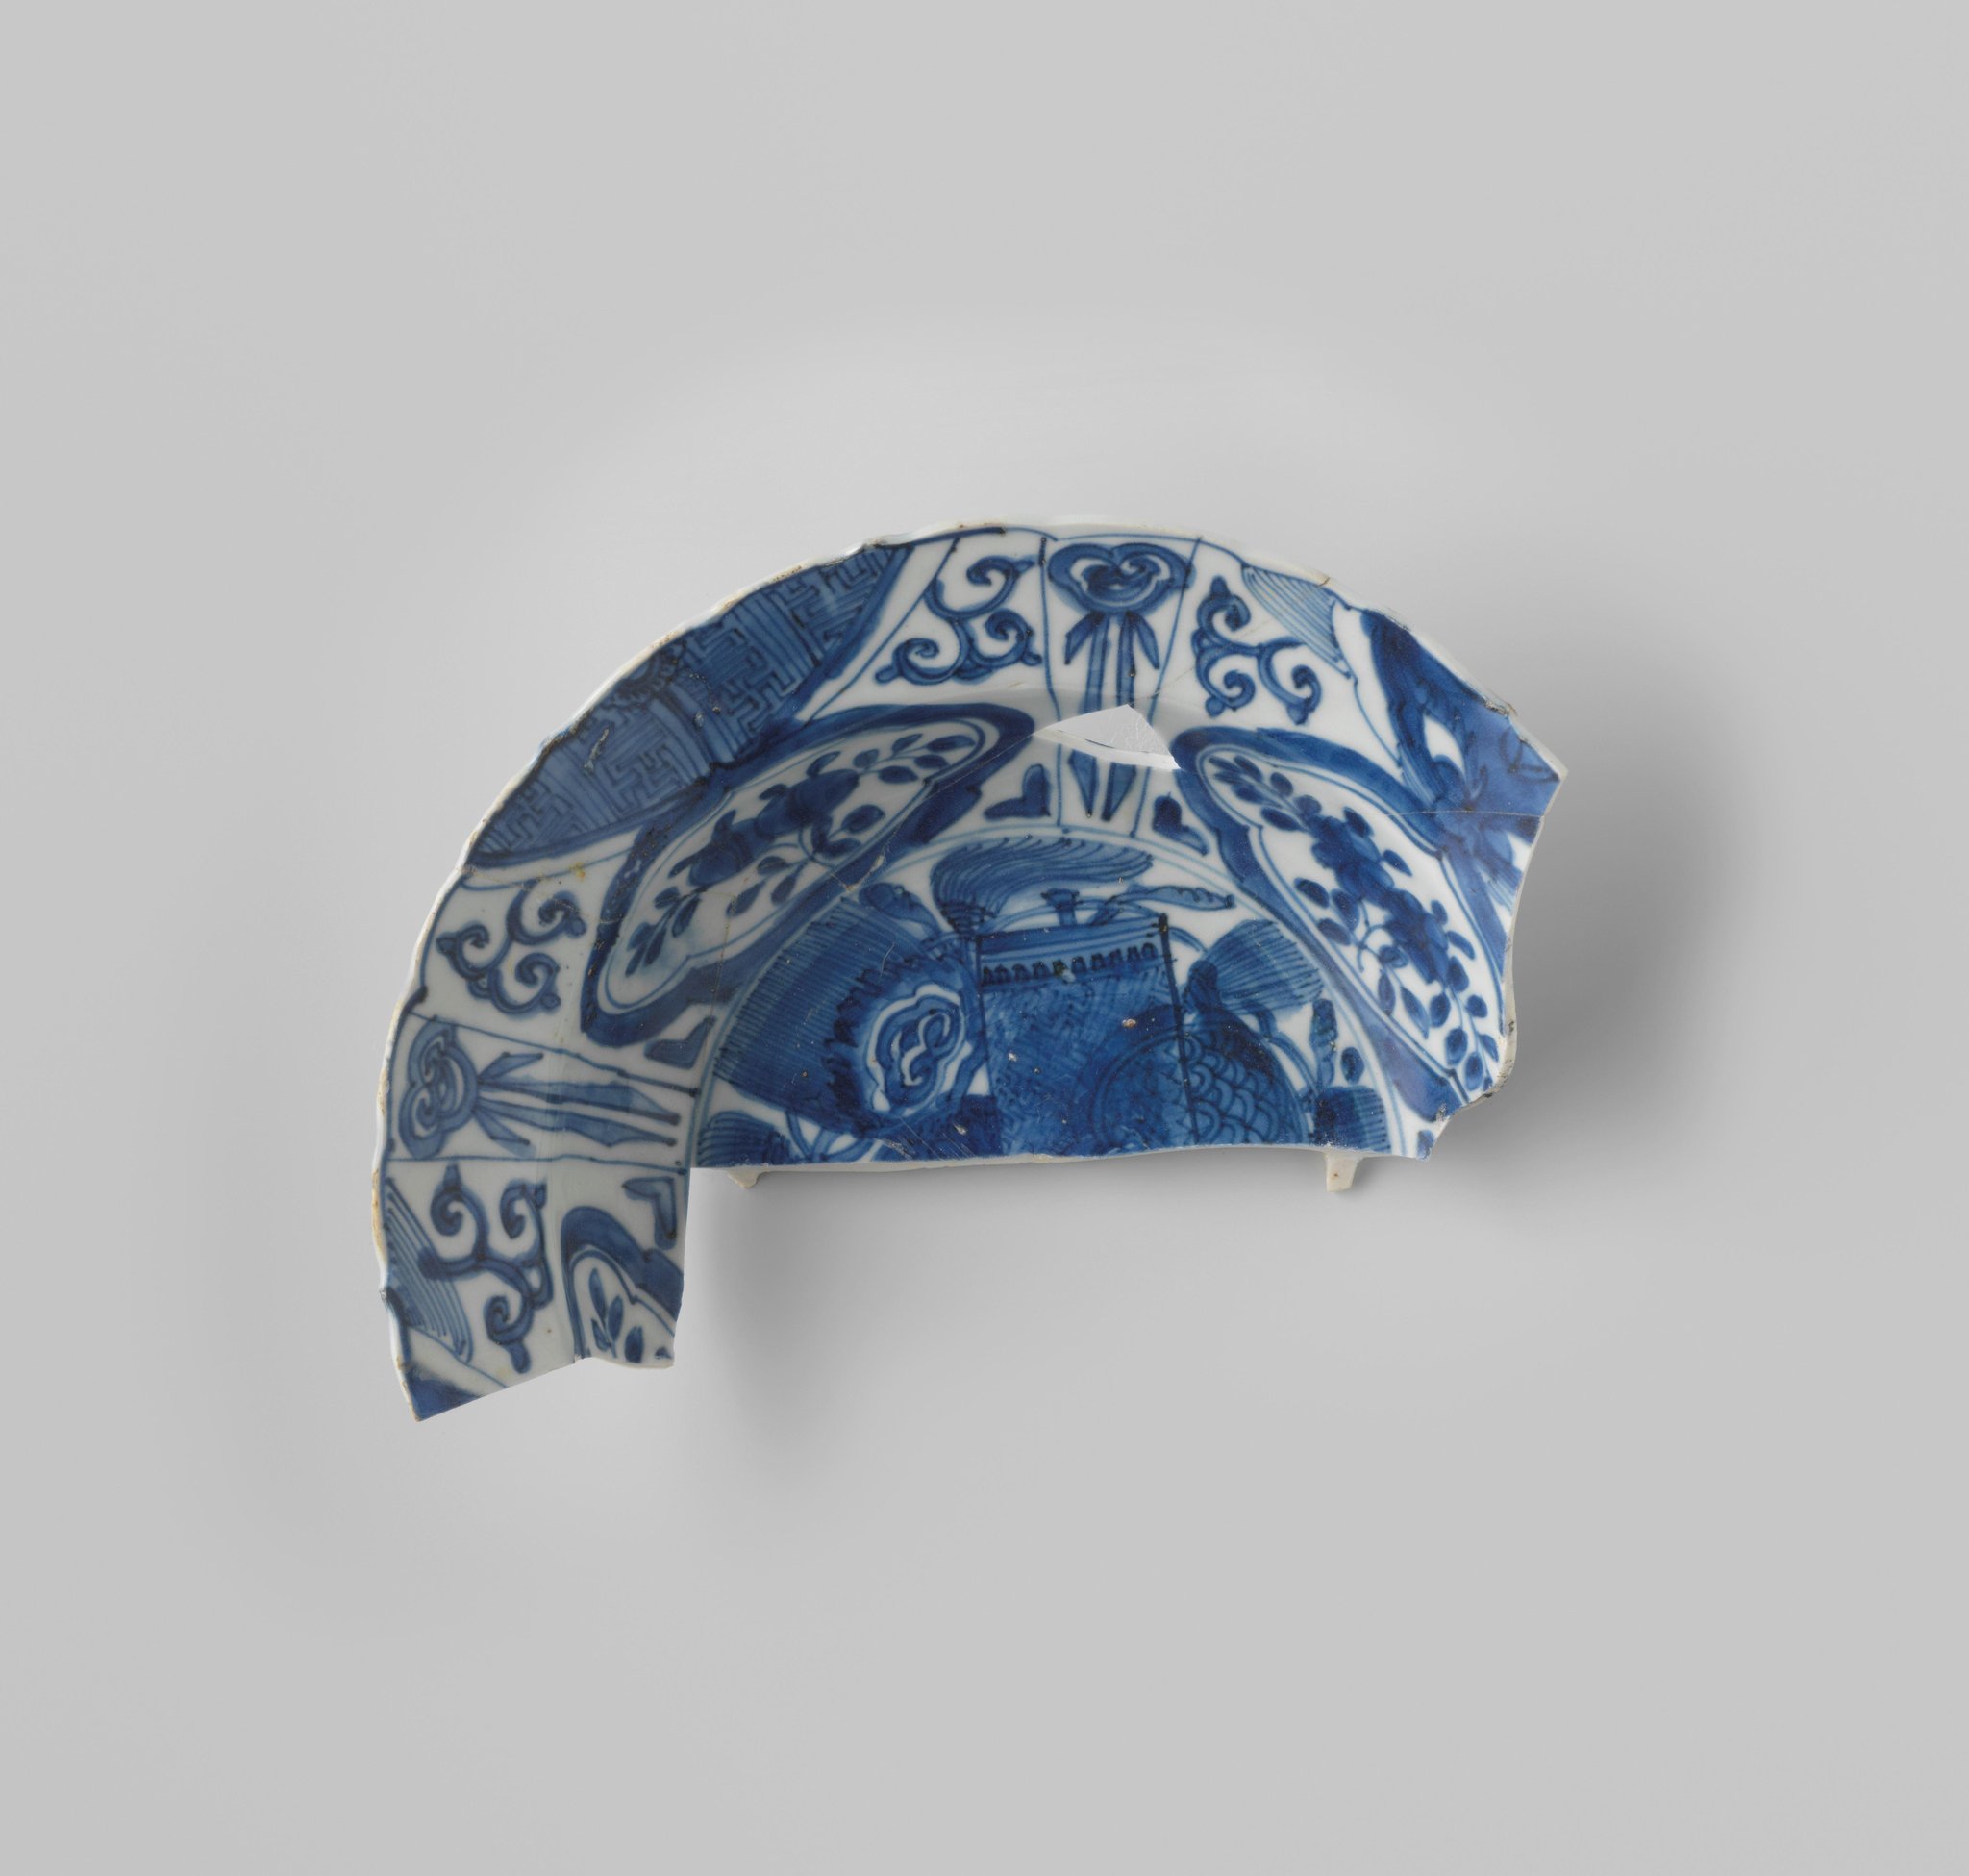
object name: deep dish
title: Fragment diep bord uit V.O.C.-schip de 'Witte Leeuw'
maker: Anonymous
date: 1613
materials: bone china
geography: jingdezhen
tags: verenigde oostindische compagnie, sint-helena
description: A bowl with a flattened rim. Taotie mask and/or borders with diaper patterns. A central decoration of a butterfly and a grasshopper on a rock next to a peony. Panels decorated with flowers and fruits.